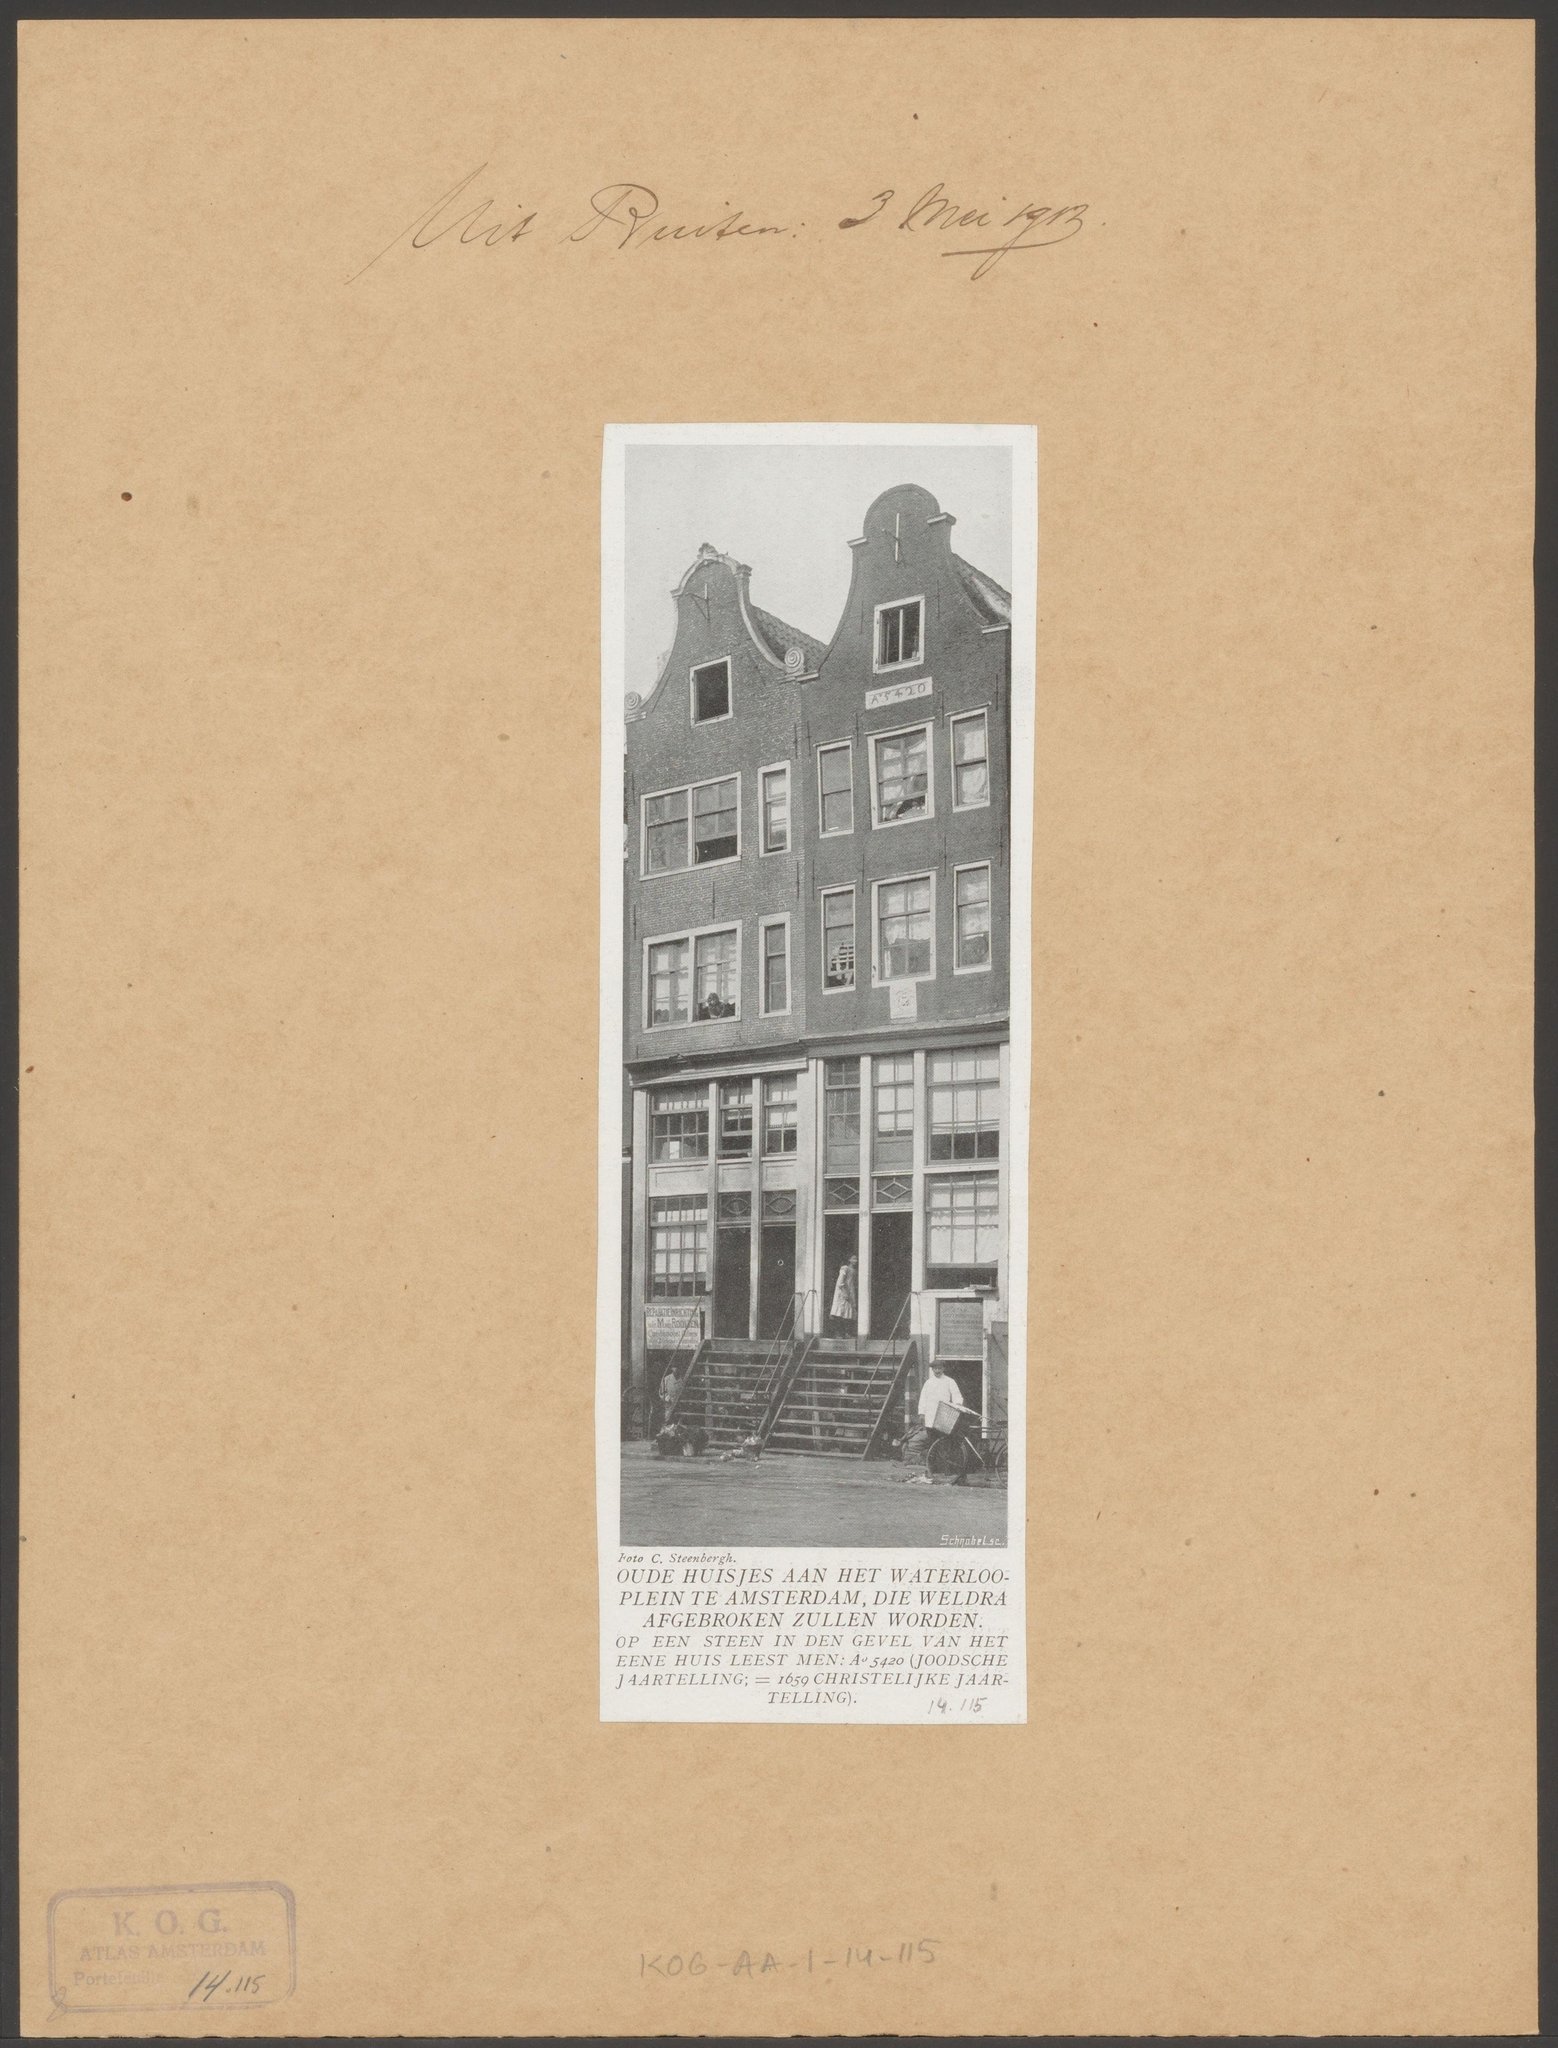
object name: photomechanical print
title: Gezicht op twee panden aan het Waterlooplein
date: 1913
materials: paper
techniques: letterpress printing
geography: amsterdam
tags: city-view in general; 'veduta', the usual house or row of houses, façade (of house or building)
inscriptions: collector's mark: ‘14.115’ Lugt 1641b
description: Onderwerpsrubriek binnen de Atlas Amsterdam: Waal (Kromme en Oude), Walenpleintje, Warmoesgracht, Warmoesstraat, Waterlooplein, Westerdoksdijk, Westermarkt, Weteringschans, Willemspark, Willemsstraat, Wittenburg, Wittenkade (de), Wittenstraat (de).